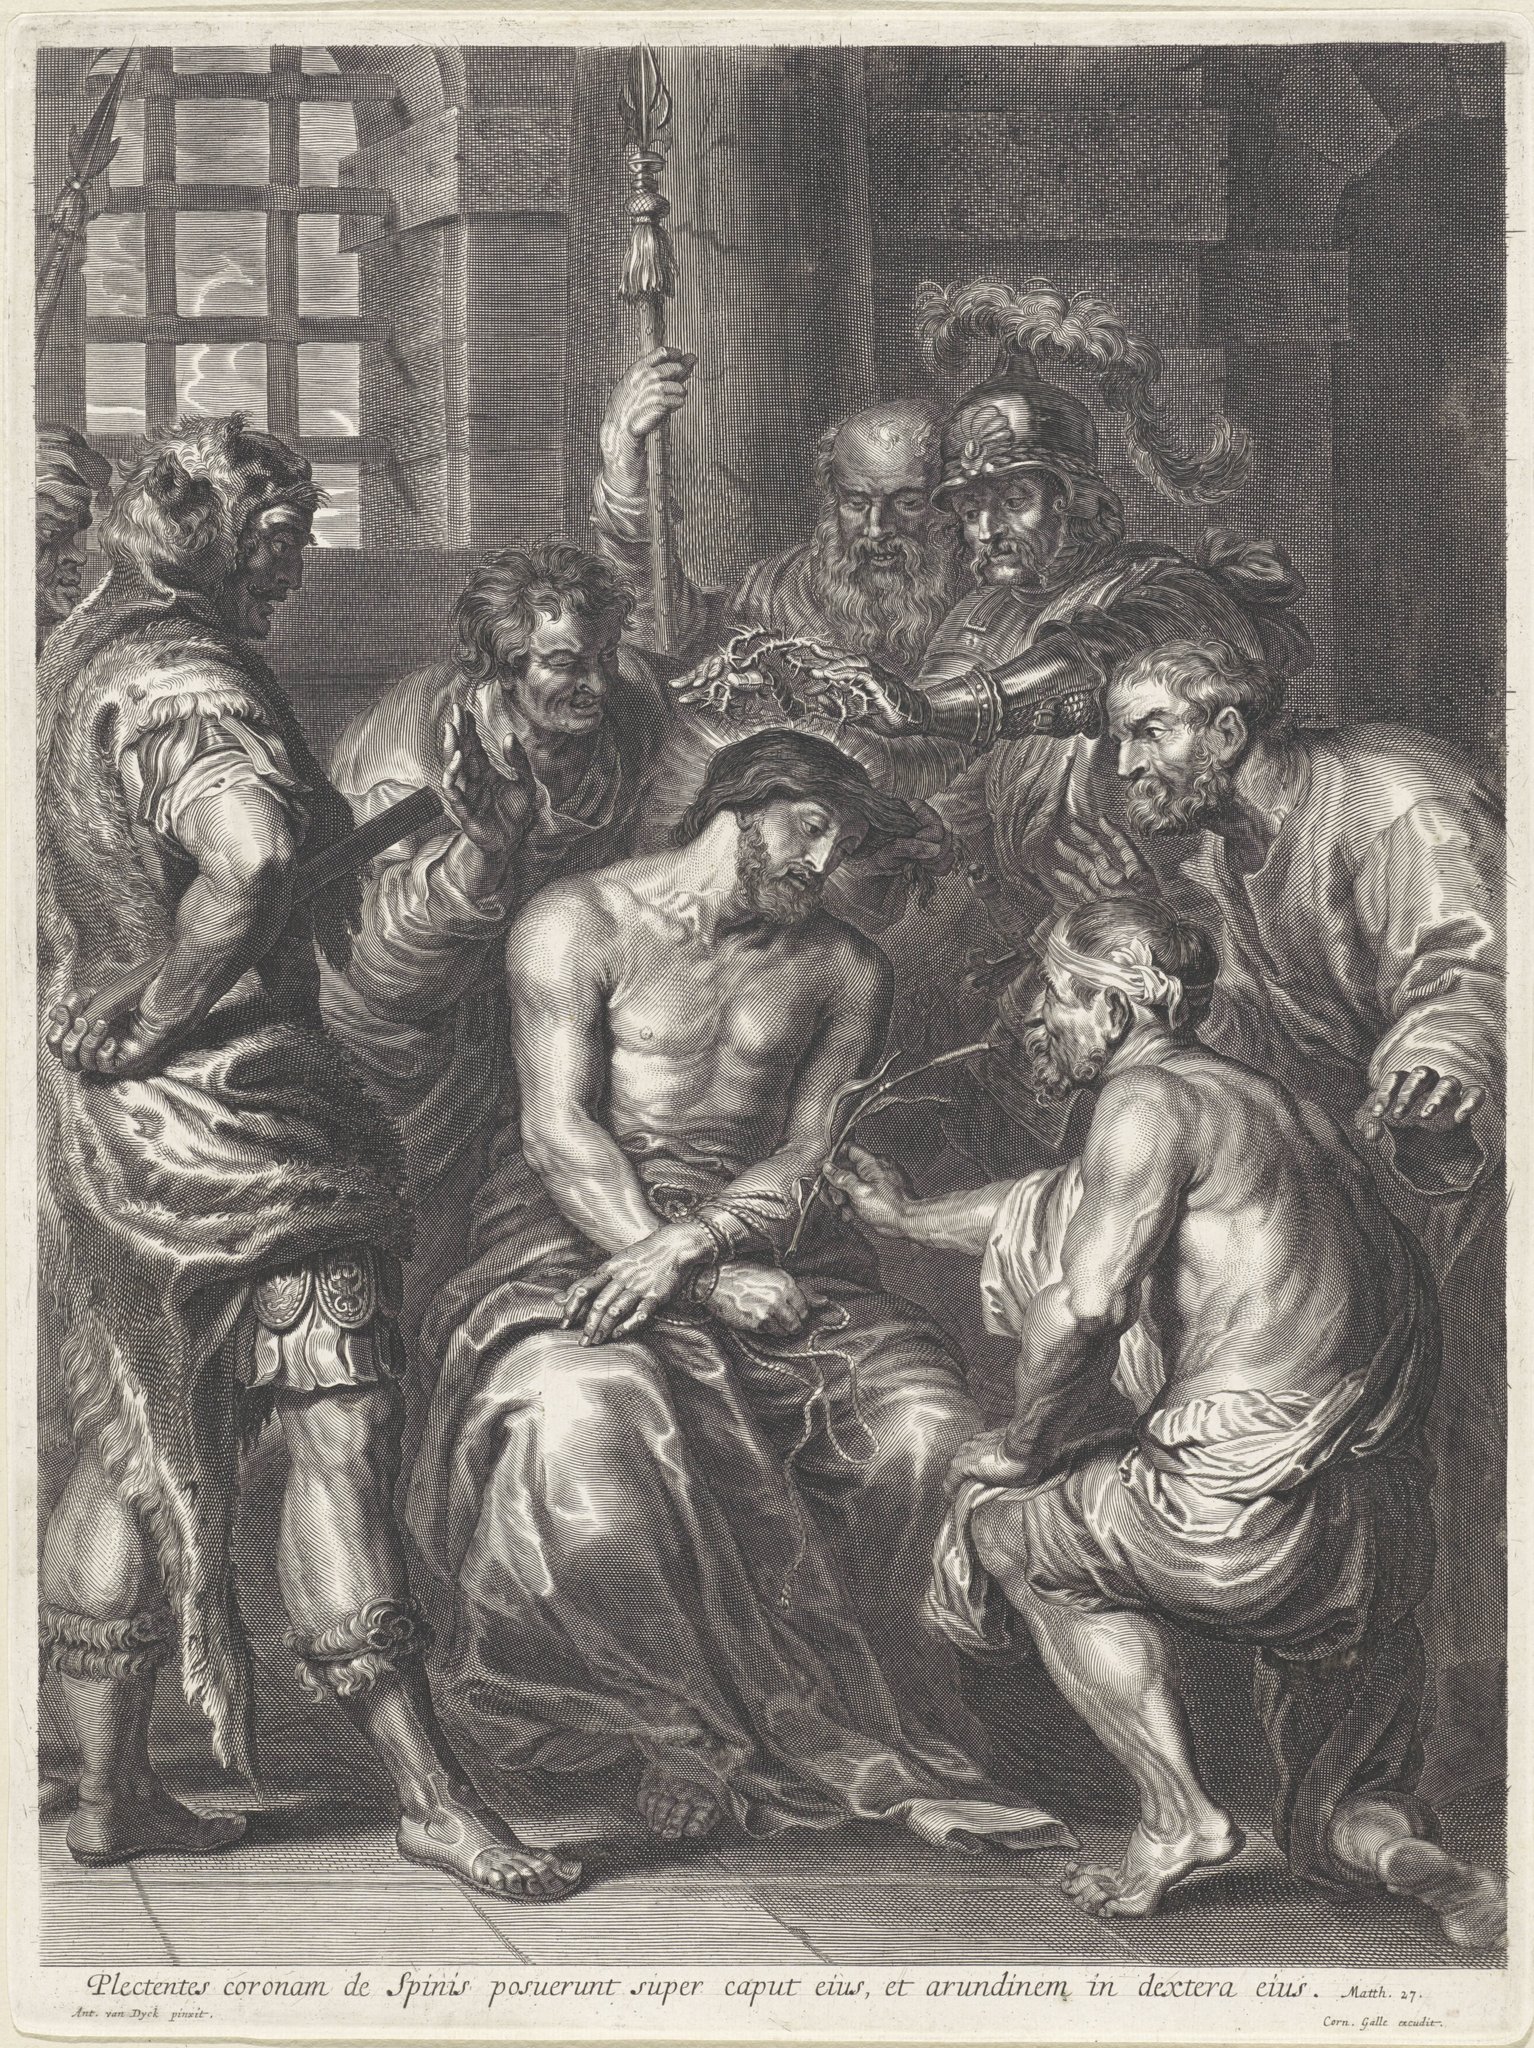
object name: print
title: Doornenkroning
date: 1615-1650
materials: paper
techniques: engraving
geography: antwerp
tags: in pilate's palace christ is mocked by soldiers (luke 22:63-65), the crowning with thorns: soldiers with sticks place a thorny crown on christ's head and give him a reed (matthew 27:27-31; mark 15:16-20; john 19:2-3)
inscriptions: collector's mark: Lugt 240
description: Christus zit te midden van enkele soldaten in het huis van Pilatus. Zijn onderlichaam wordt bedekt door een gewaad en zijn handen zijn vastgebonden. De man voor hem overhandigt hem een rietstengel als scepter en een soldaat achter hem kroont hem met een doornenkroon. In de marge een éénregelig onderschrift in het Latijn uit Mat. 27.